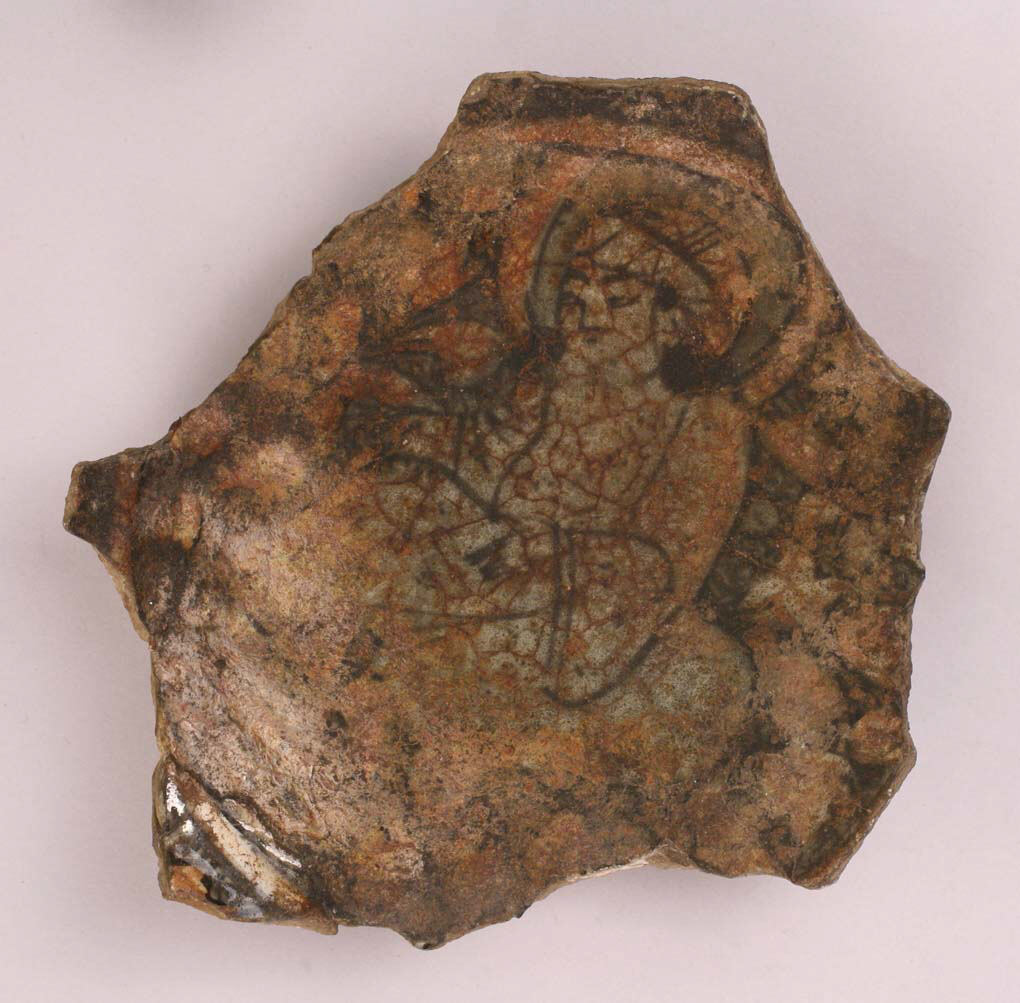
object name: ceramic fragment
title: Fragment of a Bowl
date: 1201-1400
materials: stonepaste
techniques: painting, underglaze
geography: iran